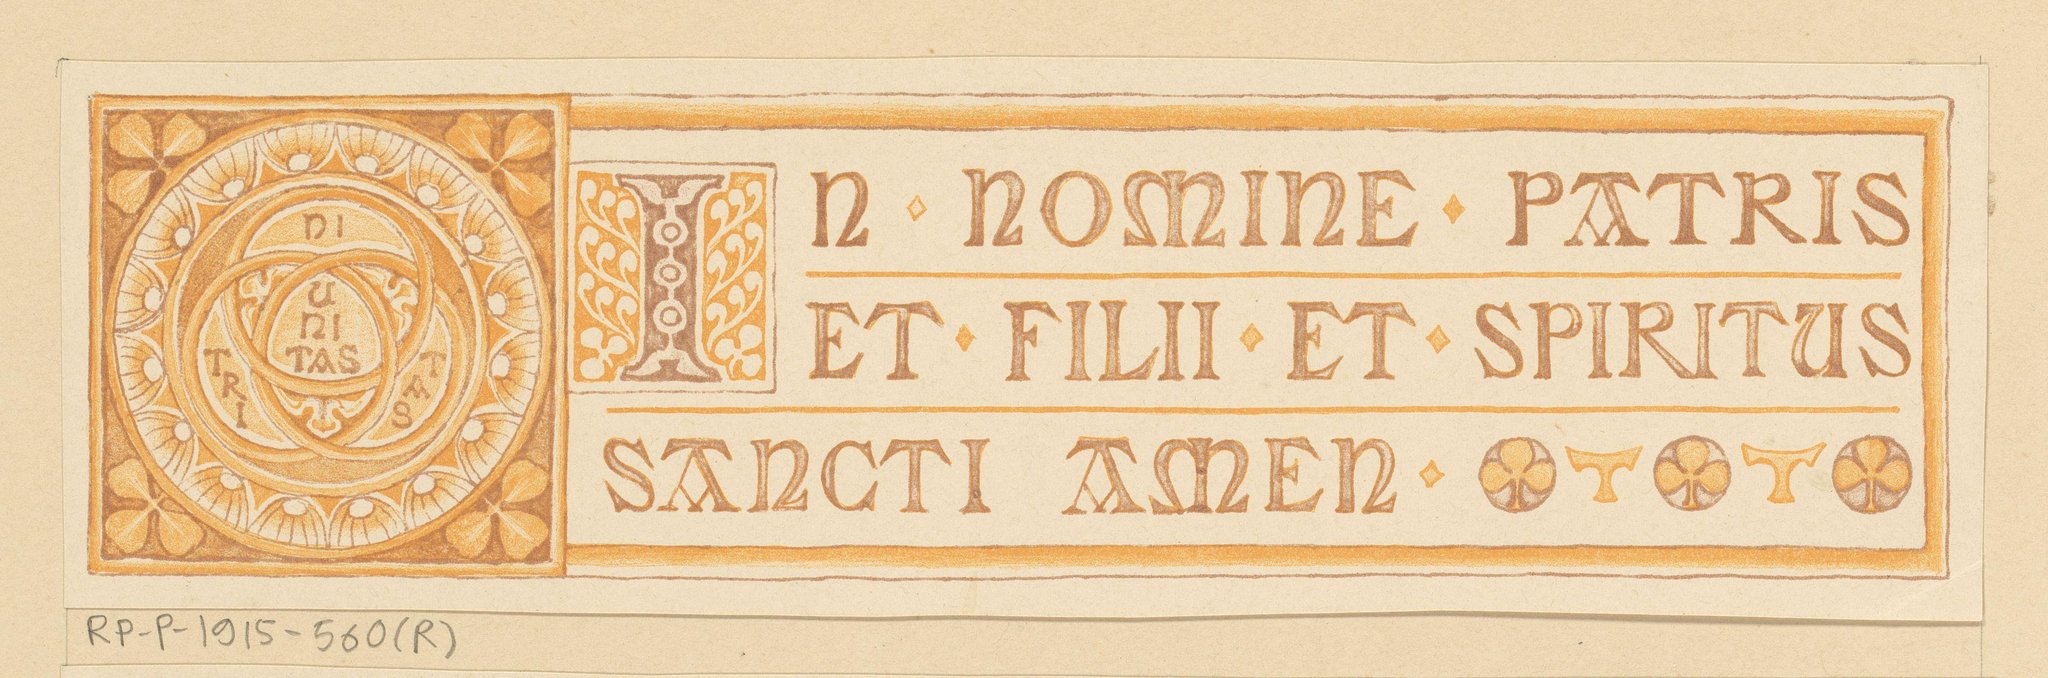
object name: print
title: In nomine Patris et Filii et Spiritus Sancti, amen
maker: antoon derkinderen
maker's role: draughtsman, painter, print maker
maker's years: 1859-1925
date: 1895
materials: paper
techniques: lithograph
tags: ornament derived from plant forms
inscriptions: collector's mark: Lugt 2233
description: Een horizontale, rechthoekige titelband met links de tekst 'Trinitas Unitas' in een cirkel versierd met plantmotieven.